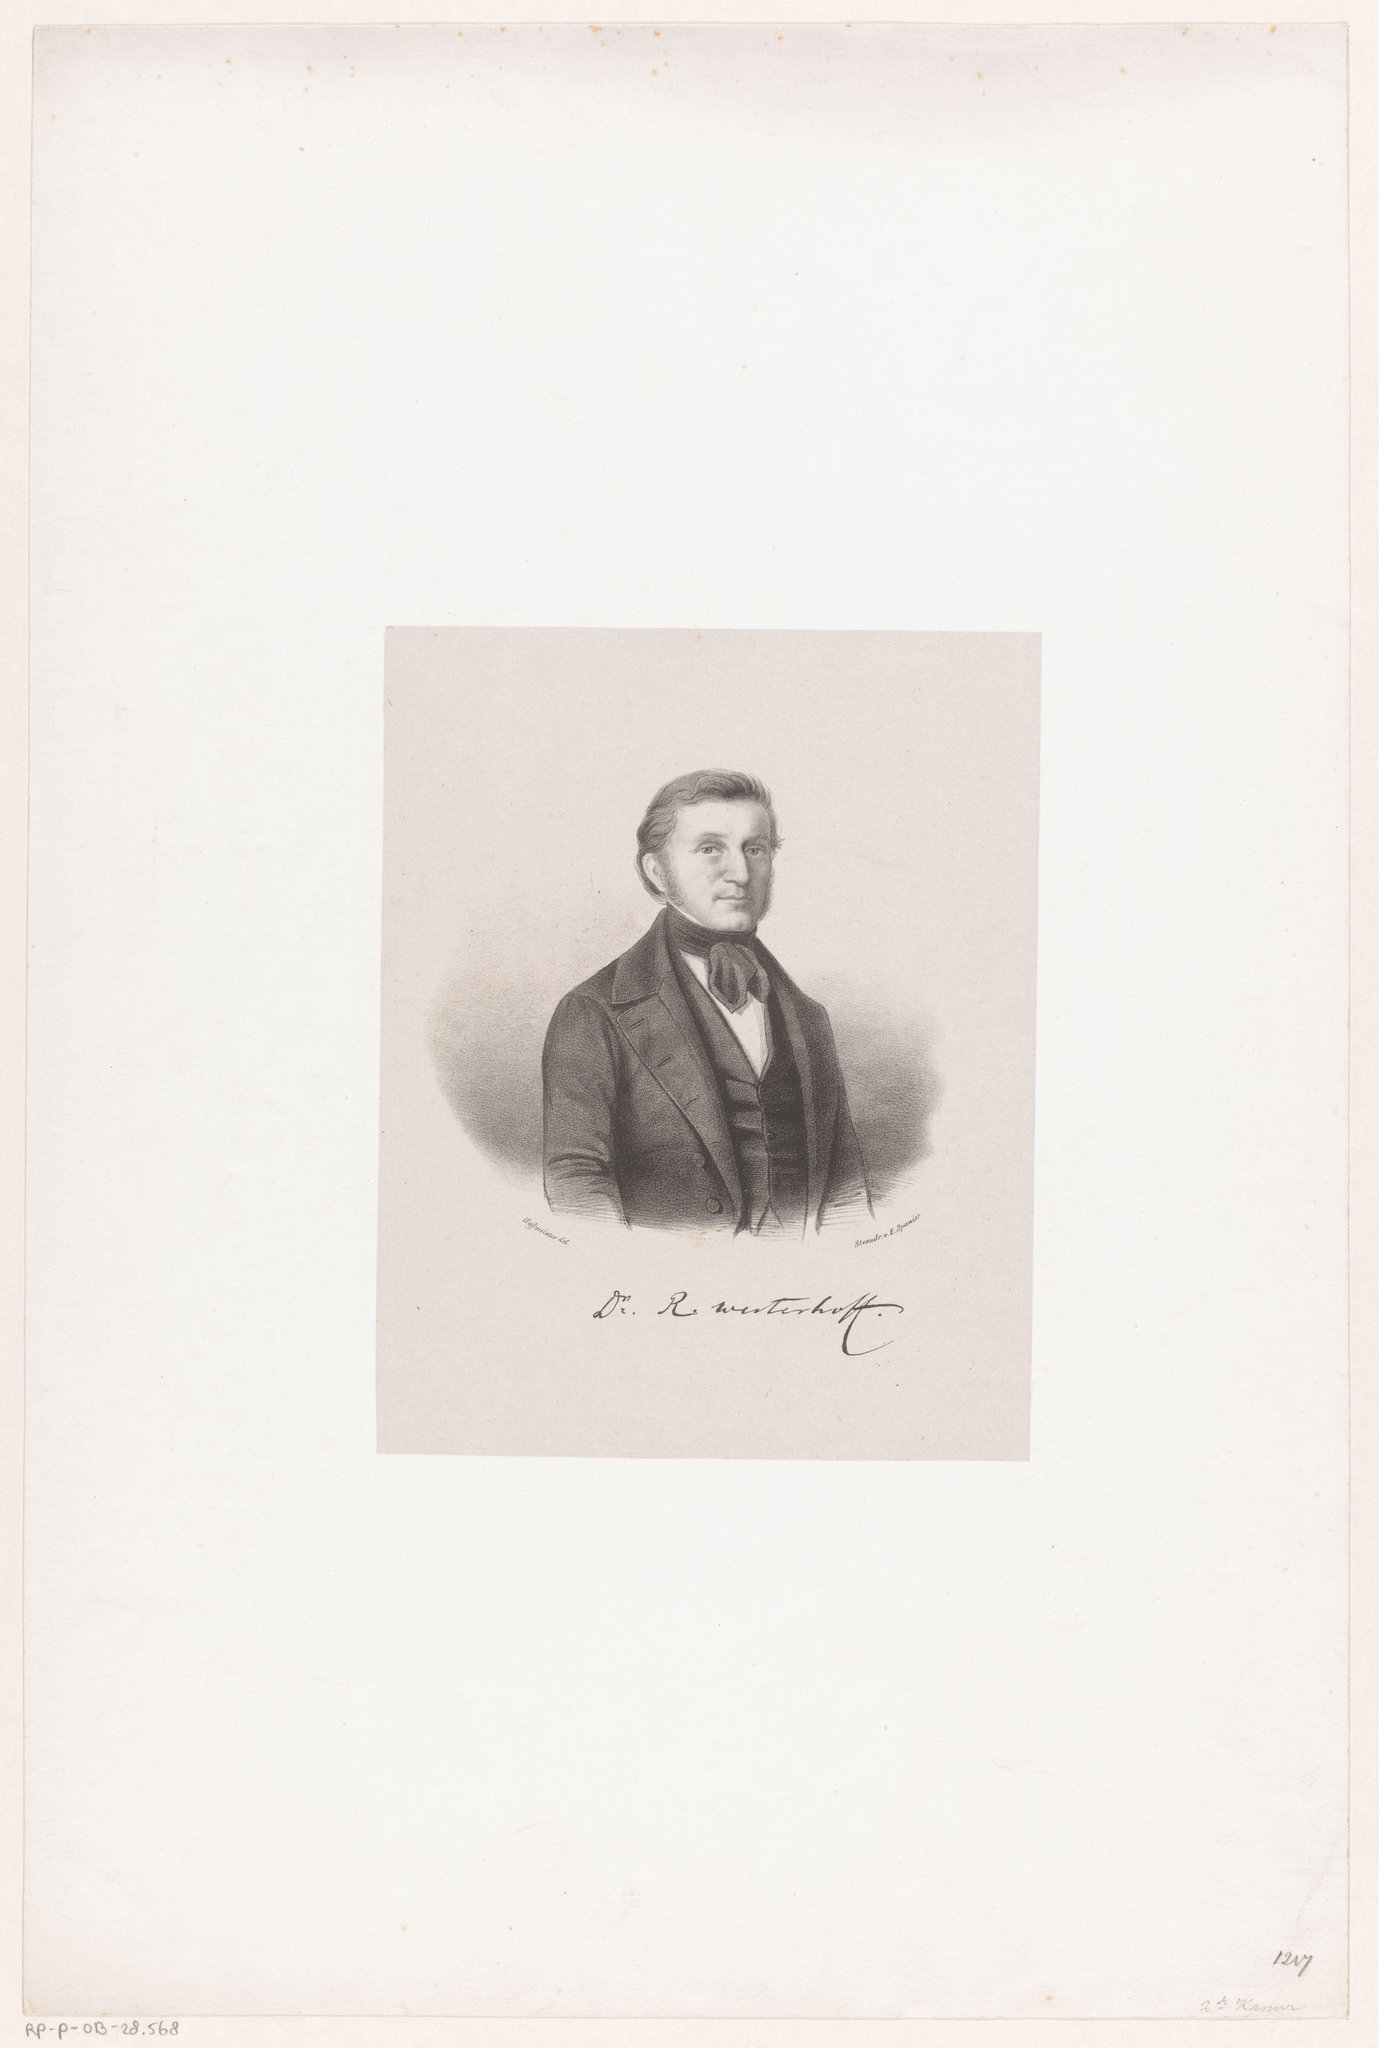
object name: print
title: Portret van Rembertus Westerhoff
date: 1843-1863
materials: paper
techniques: lithograph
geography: netherlands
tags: historical persons (+ (full) bust portrait)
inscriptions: collector's mark: Lugt 2228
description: Onder het portret de signatuur van de geportretteerde.